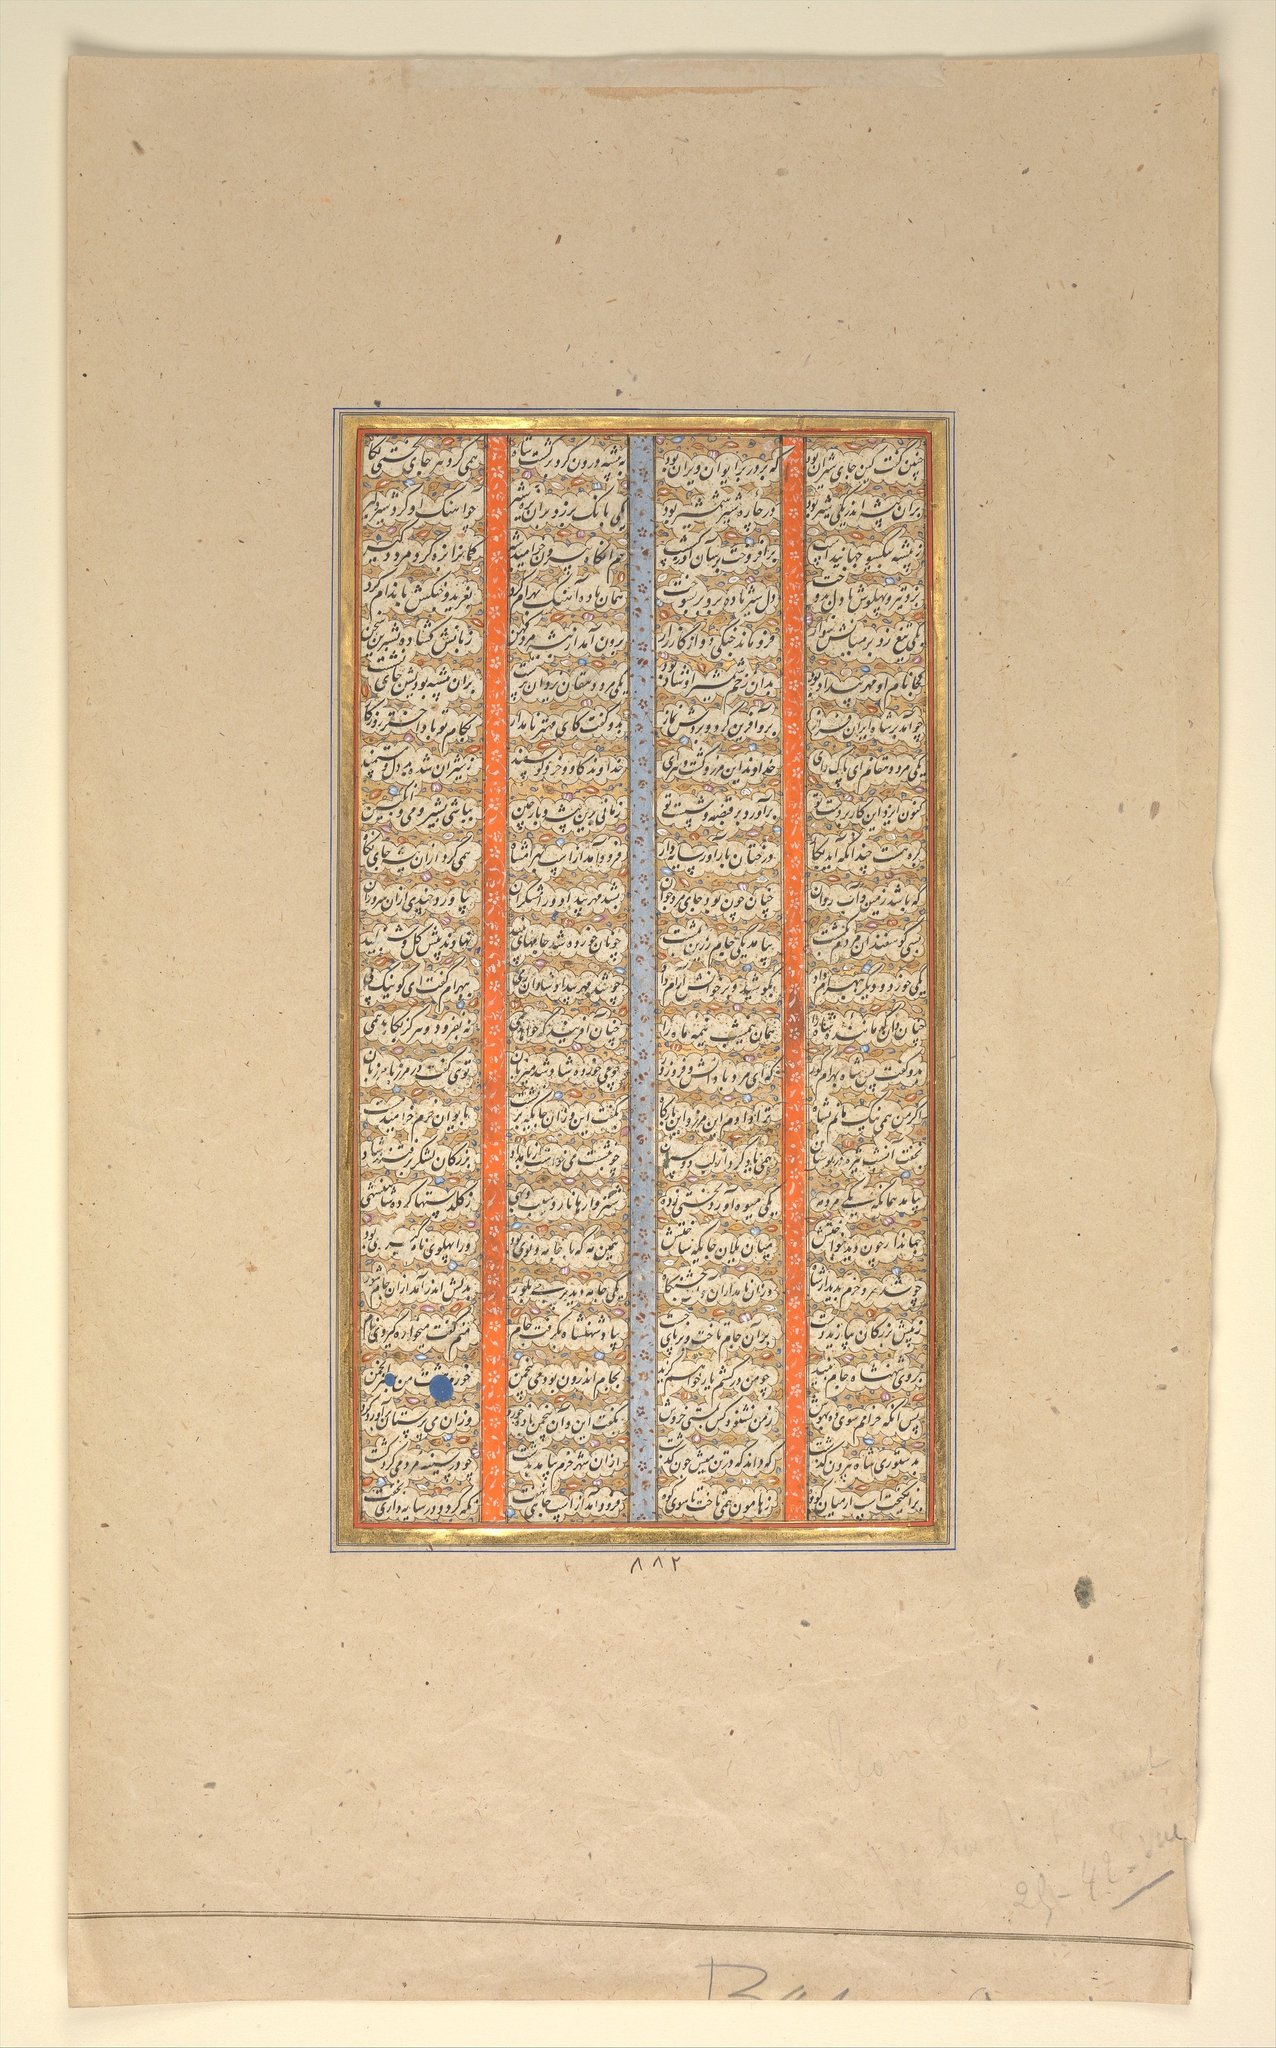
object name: folio from an illustrated manuscript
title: Page of Calligraphy from a Shahnama (Book of Kings)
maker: muhammad ibn taj al-din haidar muzahhib shirazi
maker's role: calligrapher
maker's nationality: iranian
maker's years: 1535-1605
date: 1562-1583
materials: gold, ink, paper, watercolor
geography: iran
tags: calligraphy